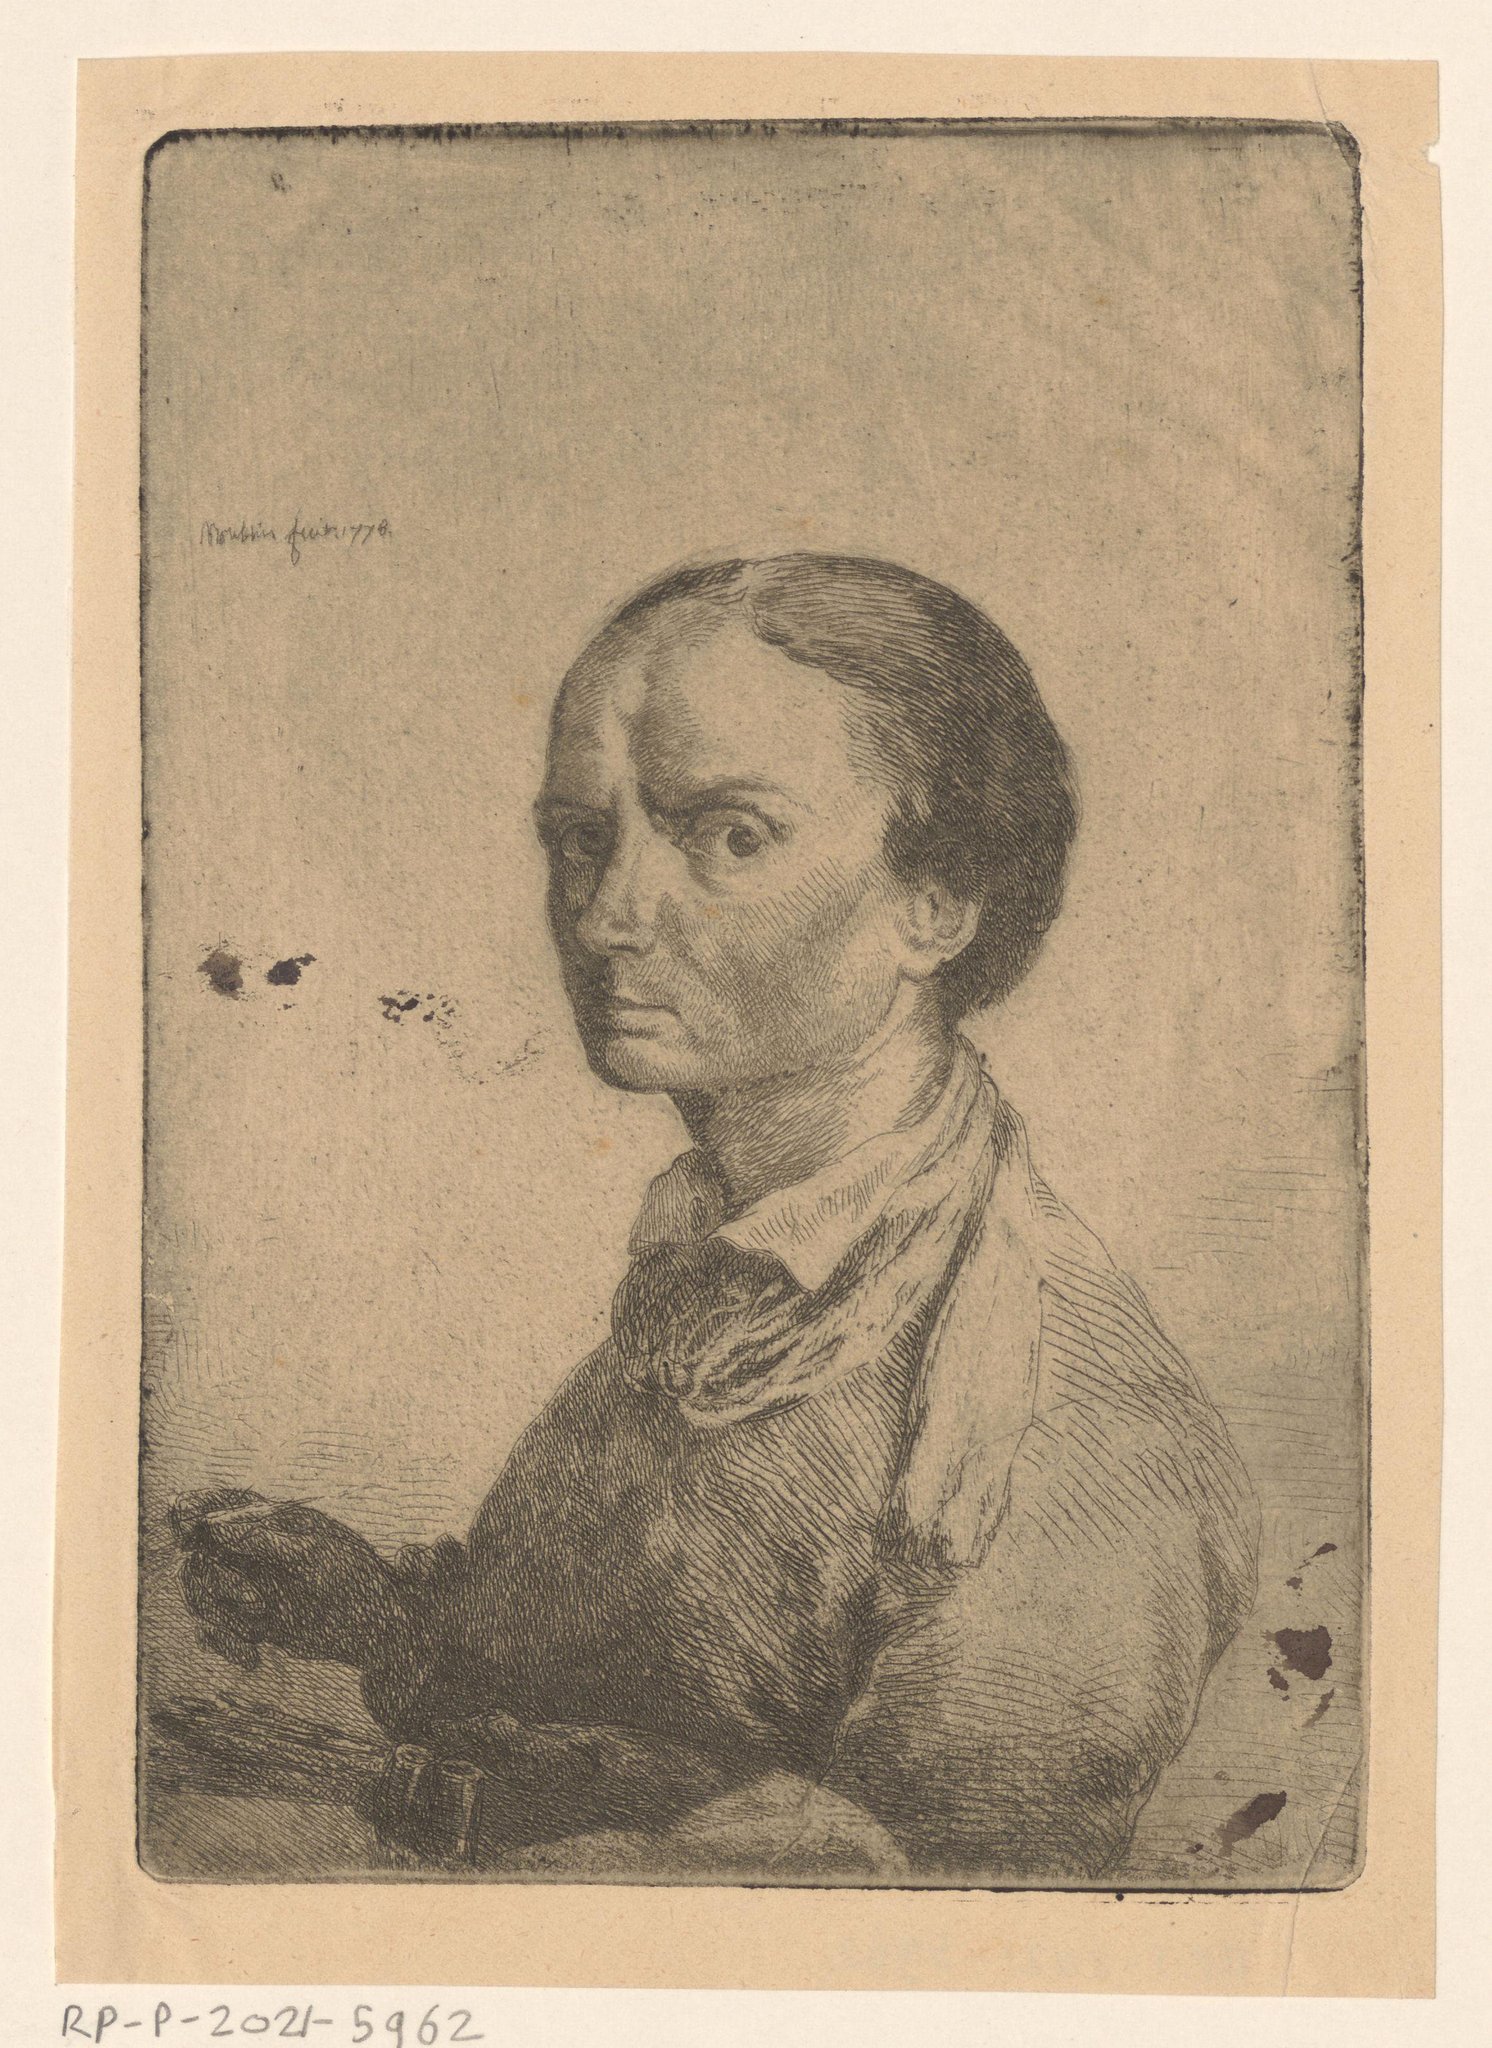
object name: print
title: Zelfportret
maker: jean pierre norblin de la gourdaine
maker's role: print maker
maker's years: 1745-1830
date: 1778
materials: paper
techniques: etching, intaglio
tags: jean pierre norblin de la gourdaine, historical persons, portrait, self-portrait of artist